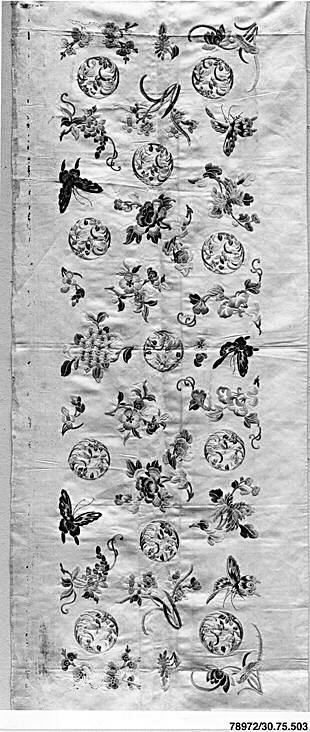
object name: sleeve band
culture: chinese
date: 1801-1900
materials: silk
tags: butterflies,leaves